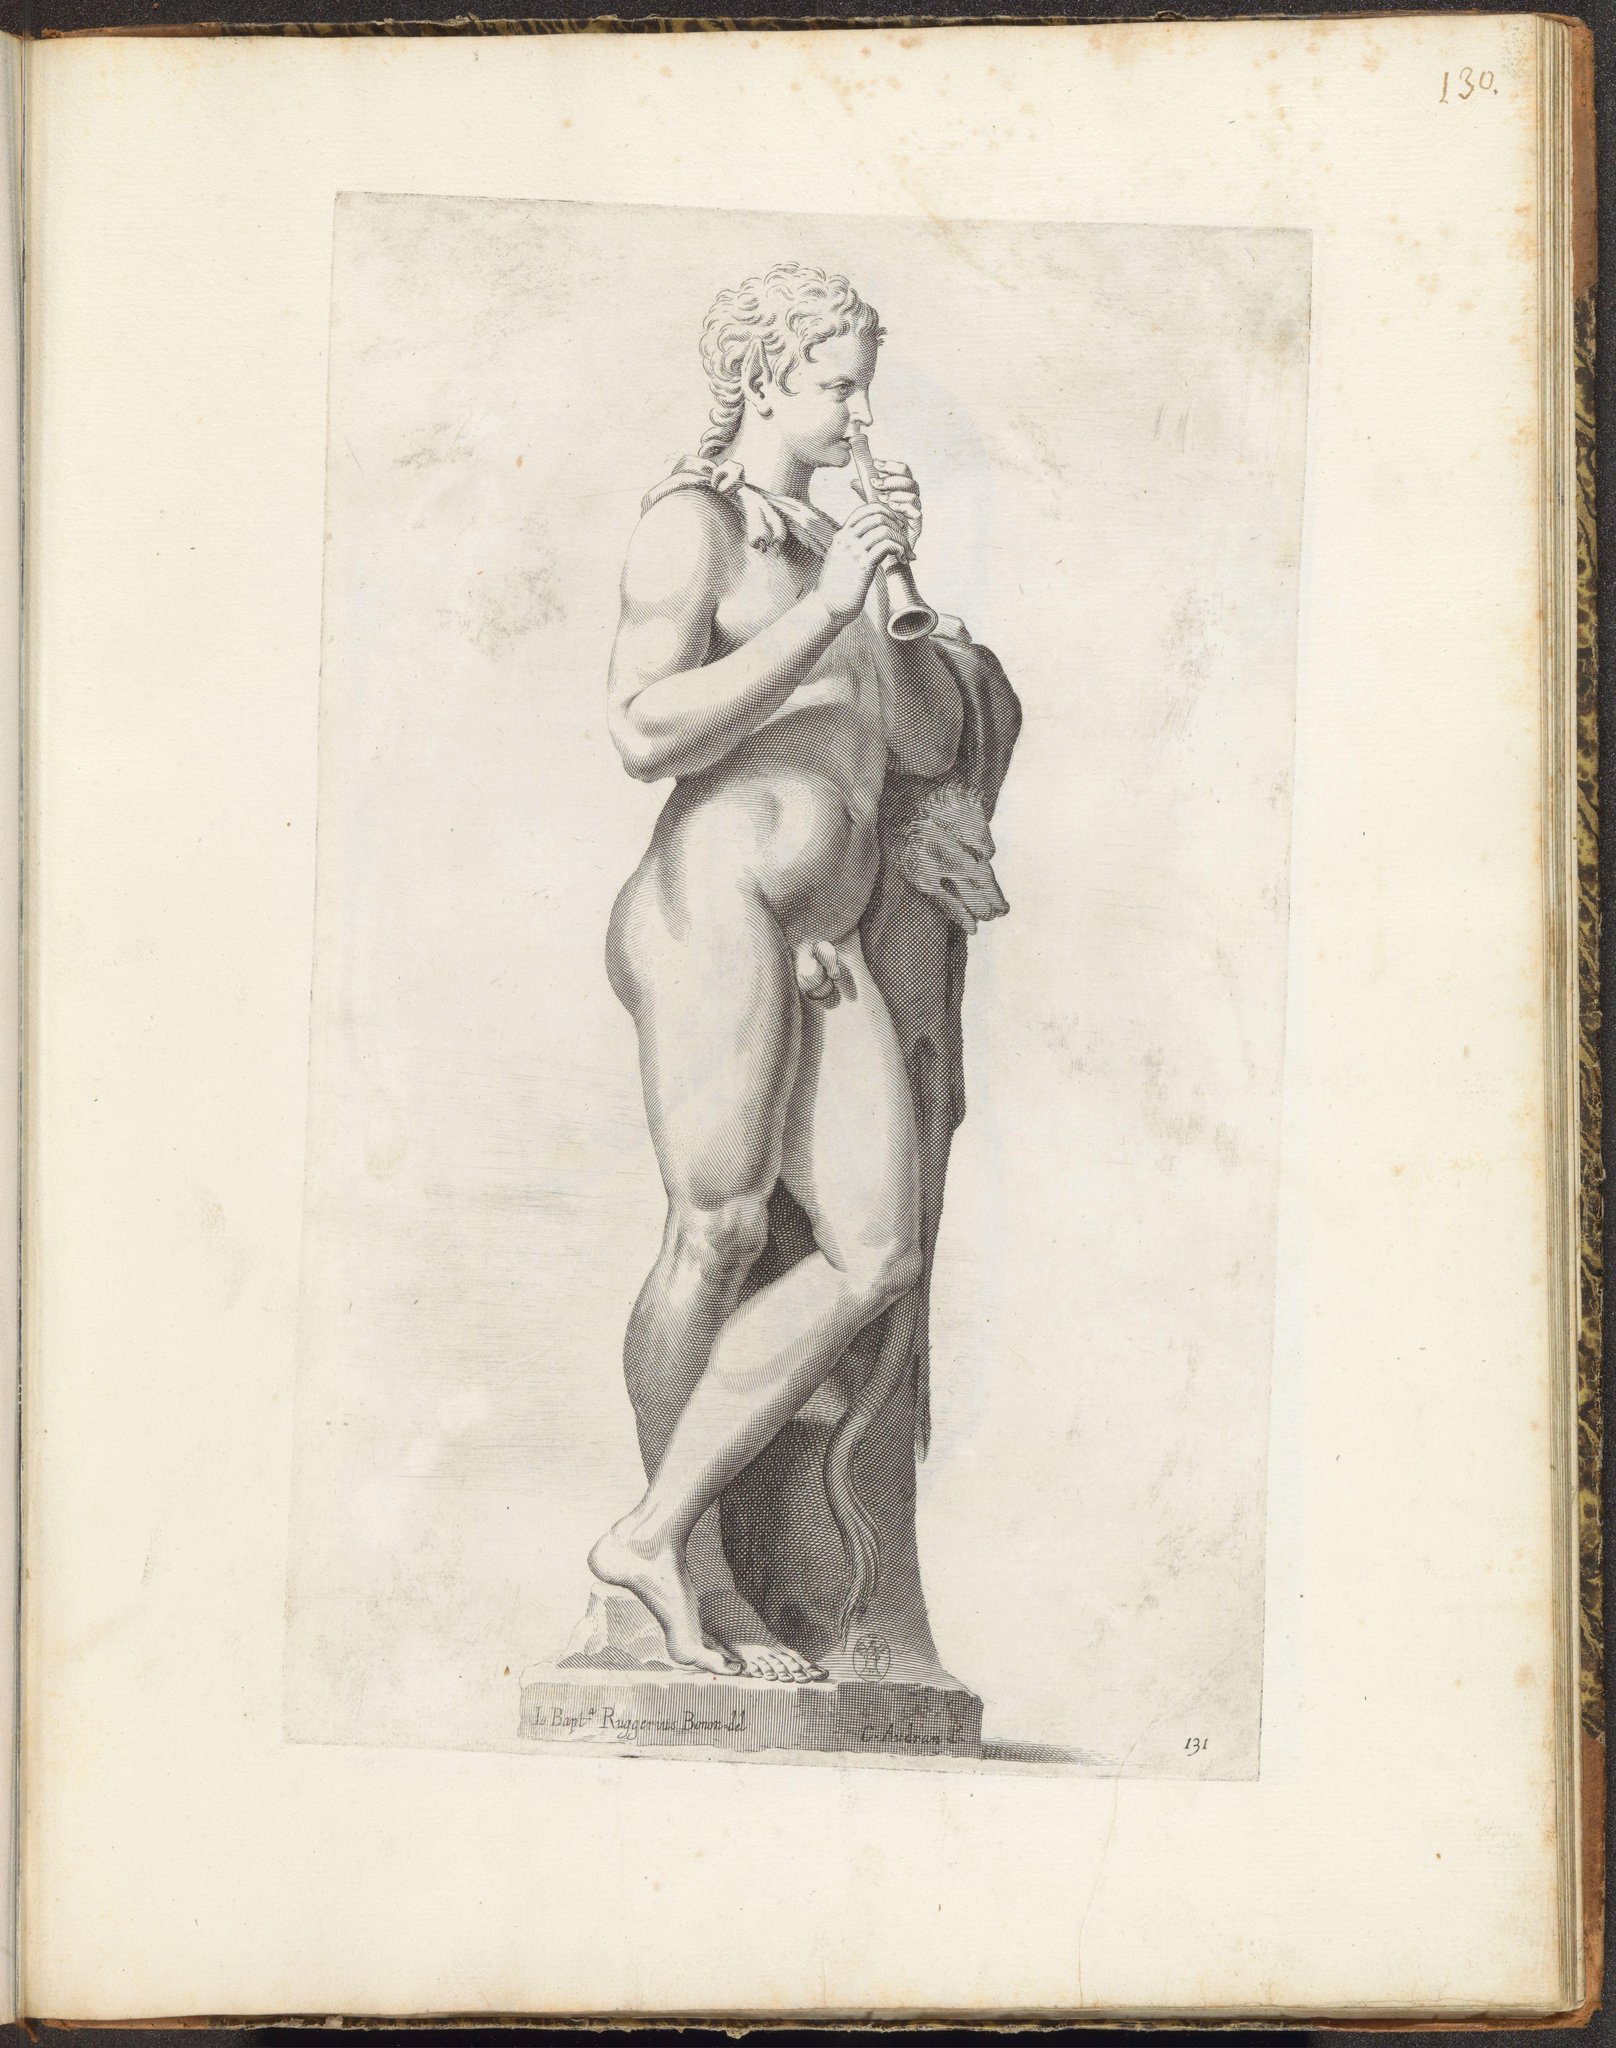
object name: print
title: Standbeeld van een faun met fluit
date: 1636-1647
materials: paper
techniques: engraving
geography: rome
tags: satyrs, fauns, sileni, piece of sculpture, reproduction of a piece of sculpture, flute, aulos, tibia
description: Standbeeld van een faun die op een fluit blaast. Onderaan op de boomstam het wapenschild van Vincenzo Giustiniani. Prent maakt deel uit van een album met een serie prenten naar de sculpturen in de verzameling in de Galleria Giustiniani te Rome.